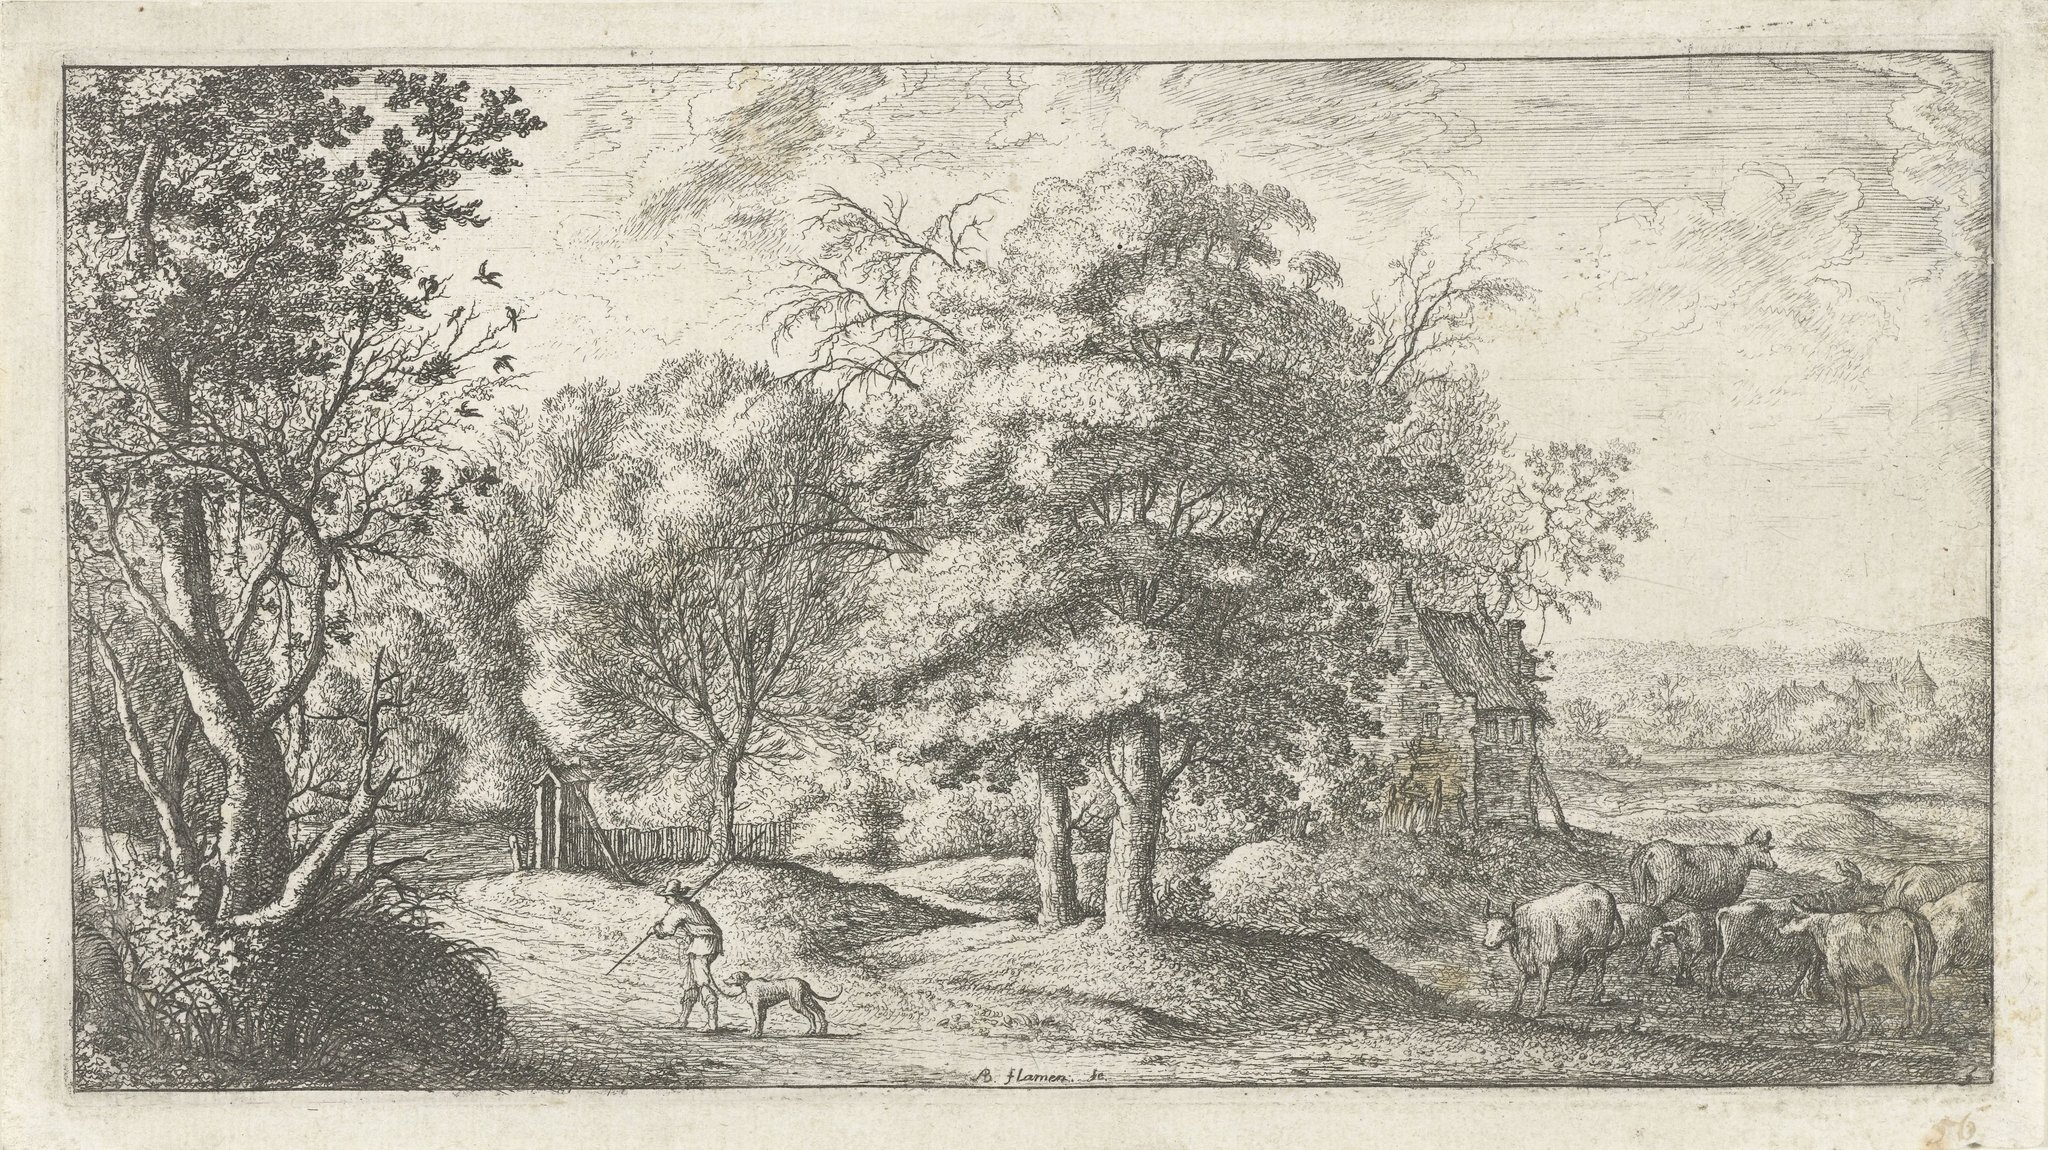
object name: print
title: Landschappen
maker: albert flamen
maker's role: draughtsman, print maker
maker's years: 1620-1691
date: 1648-1672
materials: paper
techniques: etching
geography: paris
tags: landscapes, dog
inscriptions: collector's mark: Lugt 2228, collector's mark: Lugt 2161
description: Op een pad tussen hoge bomen loopt een man met een aangelijnde hond. Naast het pad enkele koeien bij een klein huis.